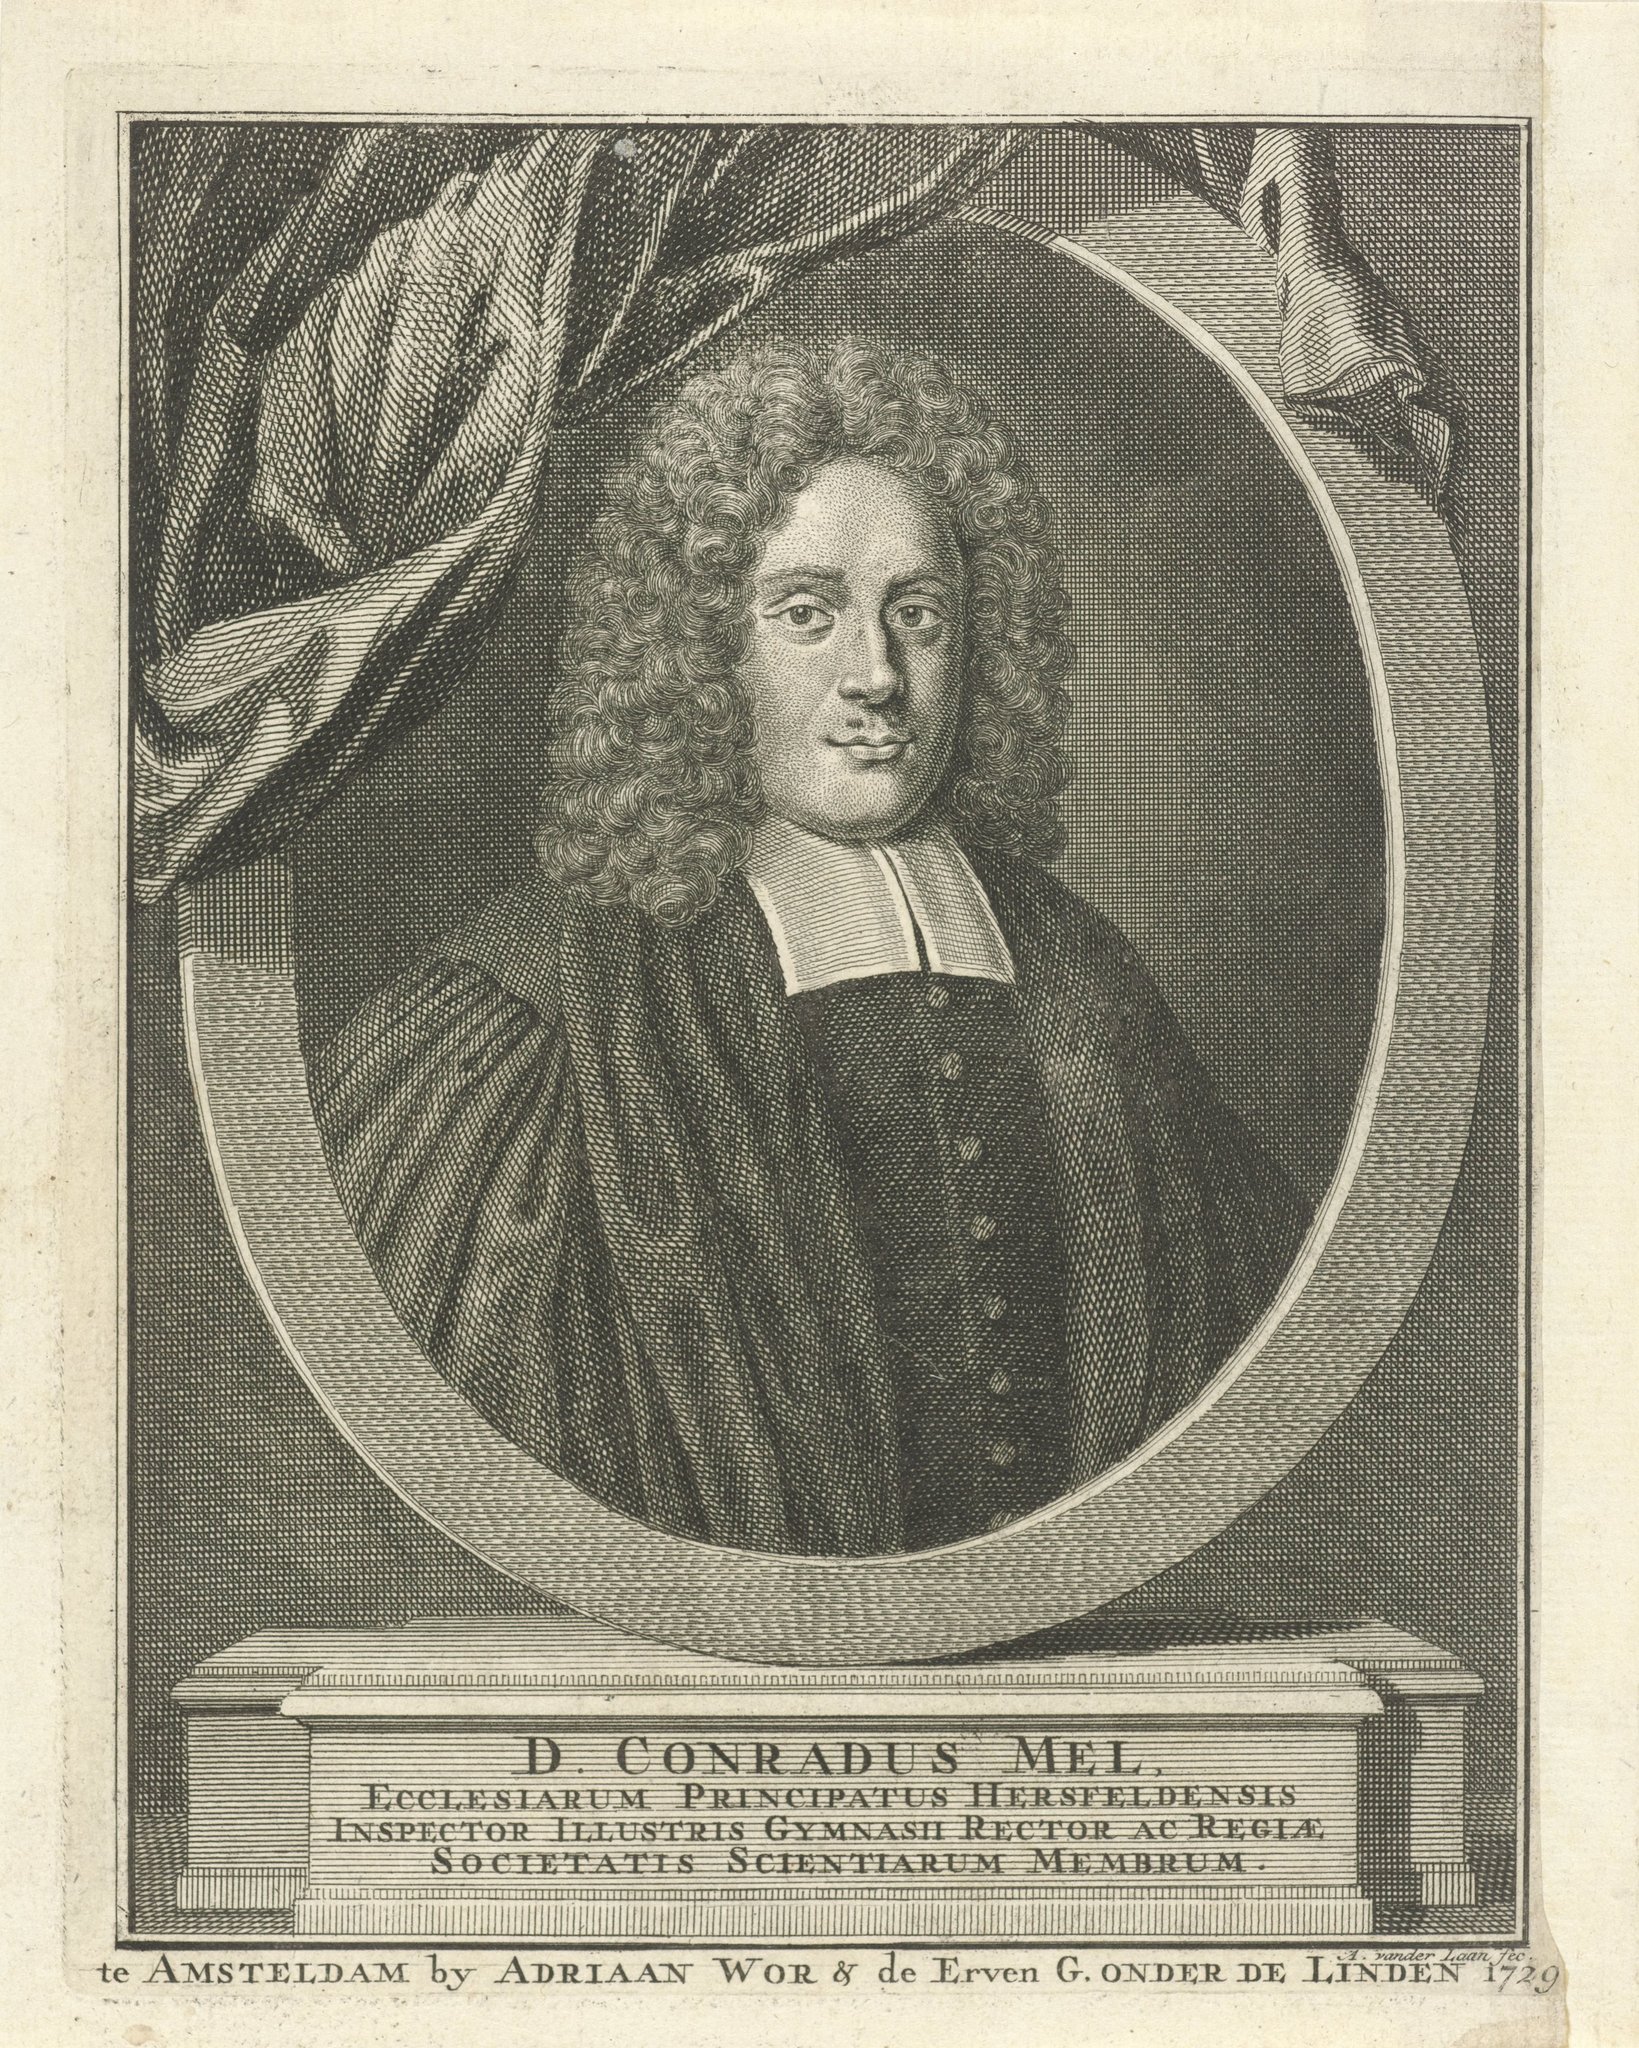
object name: print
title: Portret van Conradus Mel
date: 1729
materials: paper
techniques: engraving, etching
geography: amsterdam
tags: gudensberg, hersfeld, predikant, theoloog, professor, rector gymnasium, conrad mel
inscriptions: collector's mark: Lugt 2228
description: Portretbuste in ovaal van Conradus Mel, predikant en theoloog, blootshoofds. Het portret rust op een voetstuk waarop een opschrift in Latijn staat.